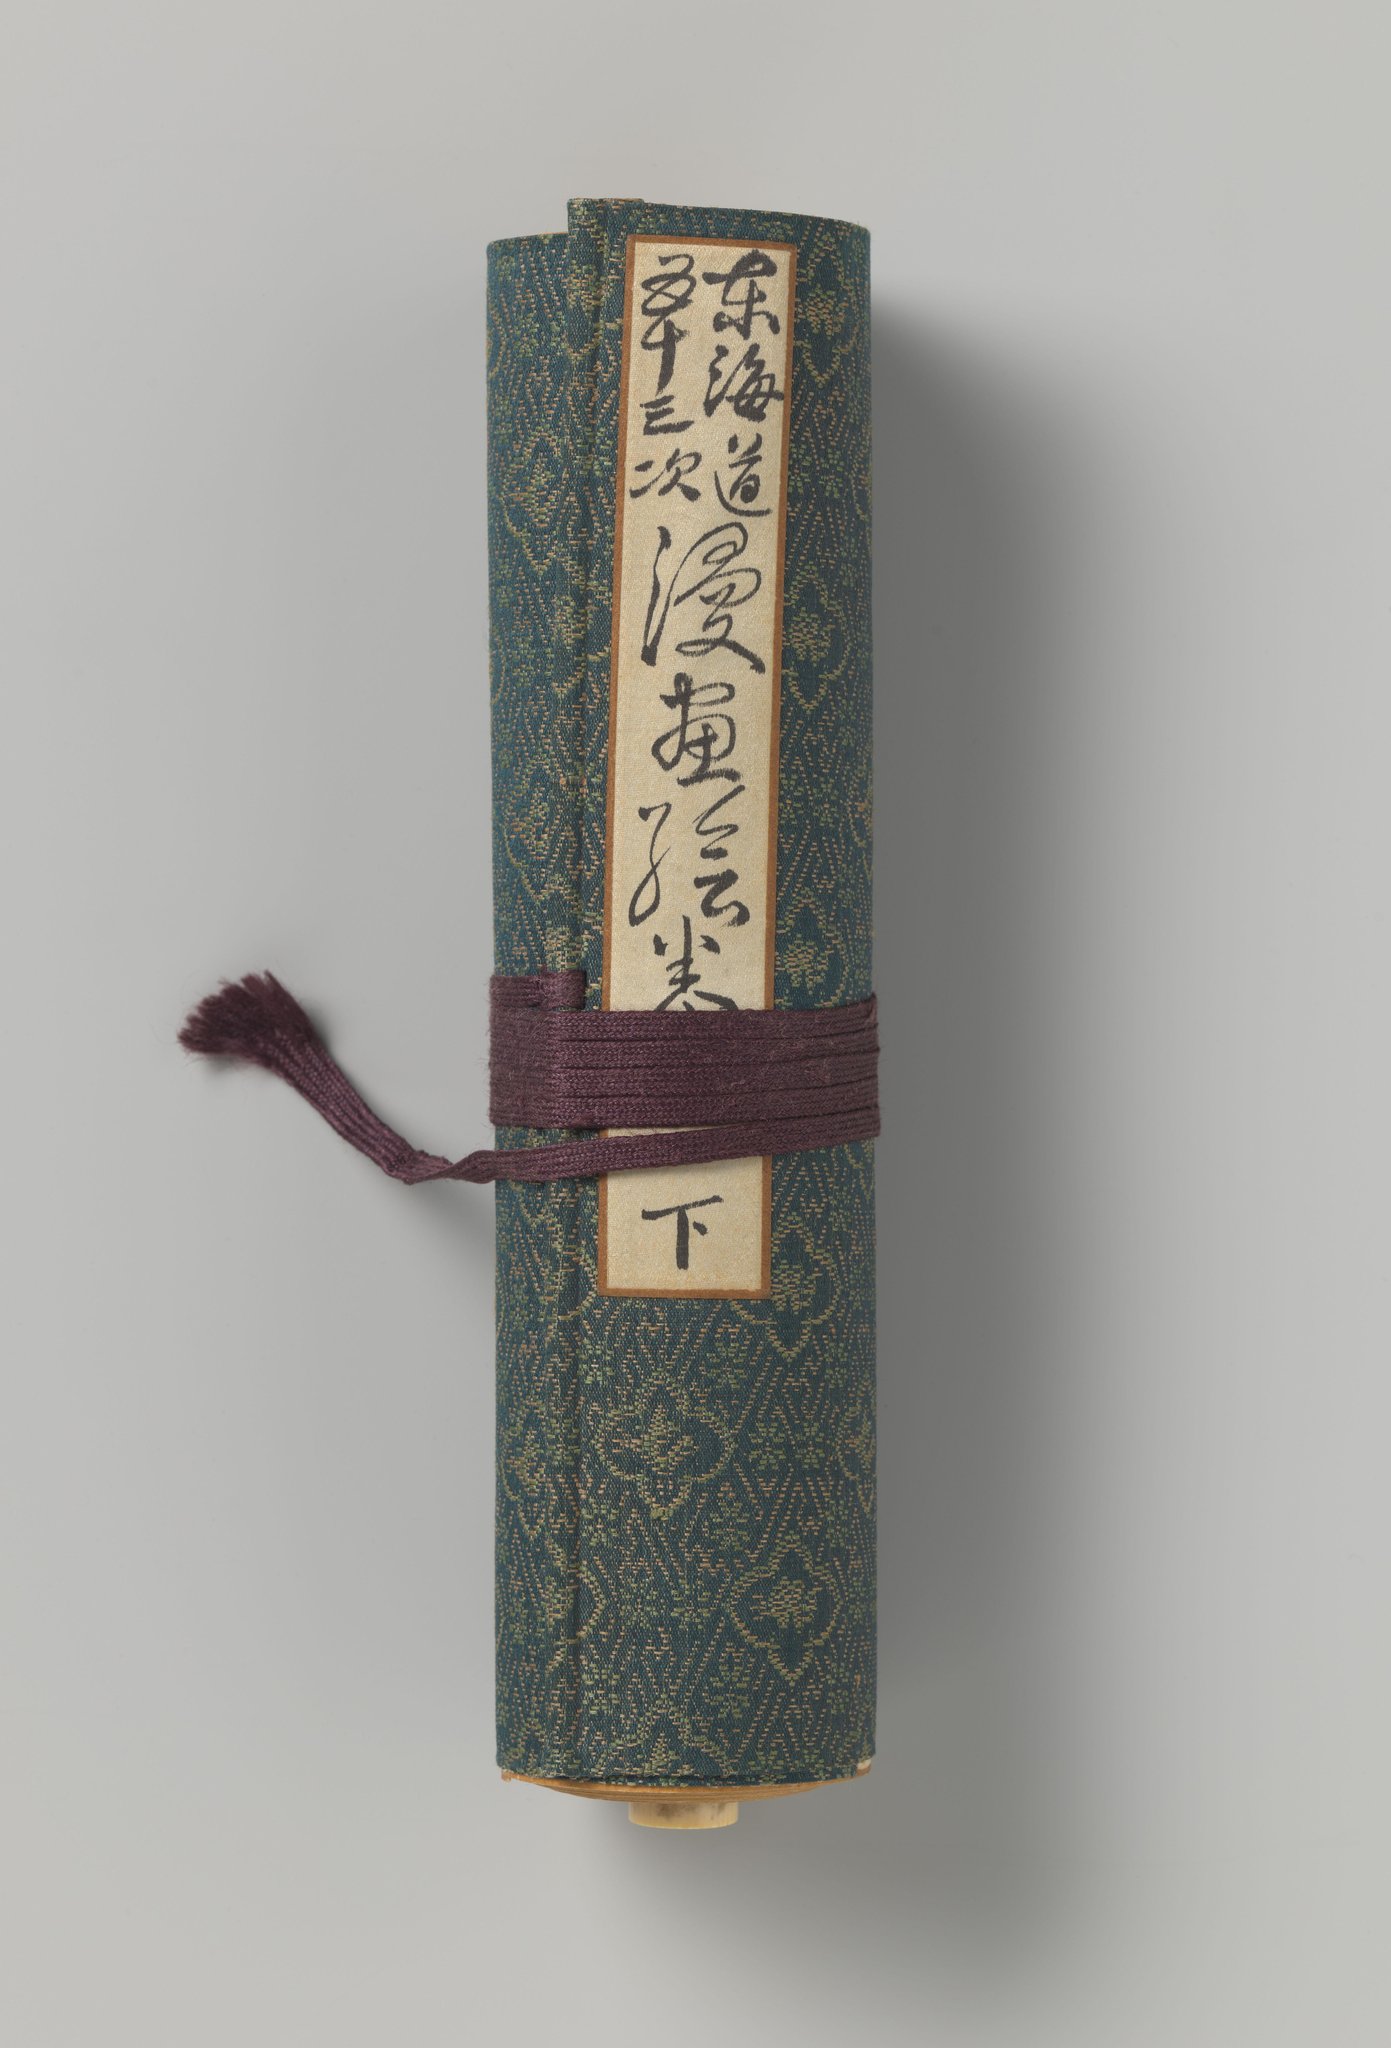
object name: hanging scroll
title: Handrol in doos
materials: paint, paper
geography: japan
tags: japan